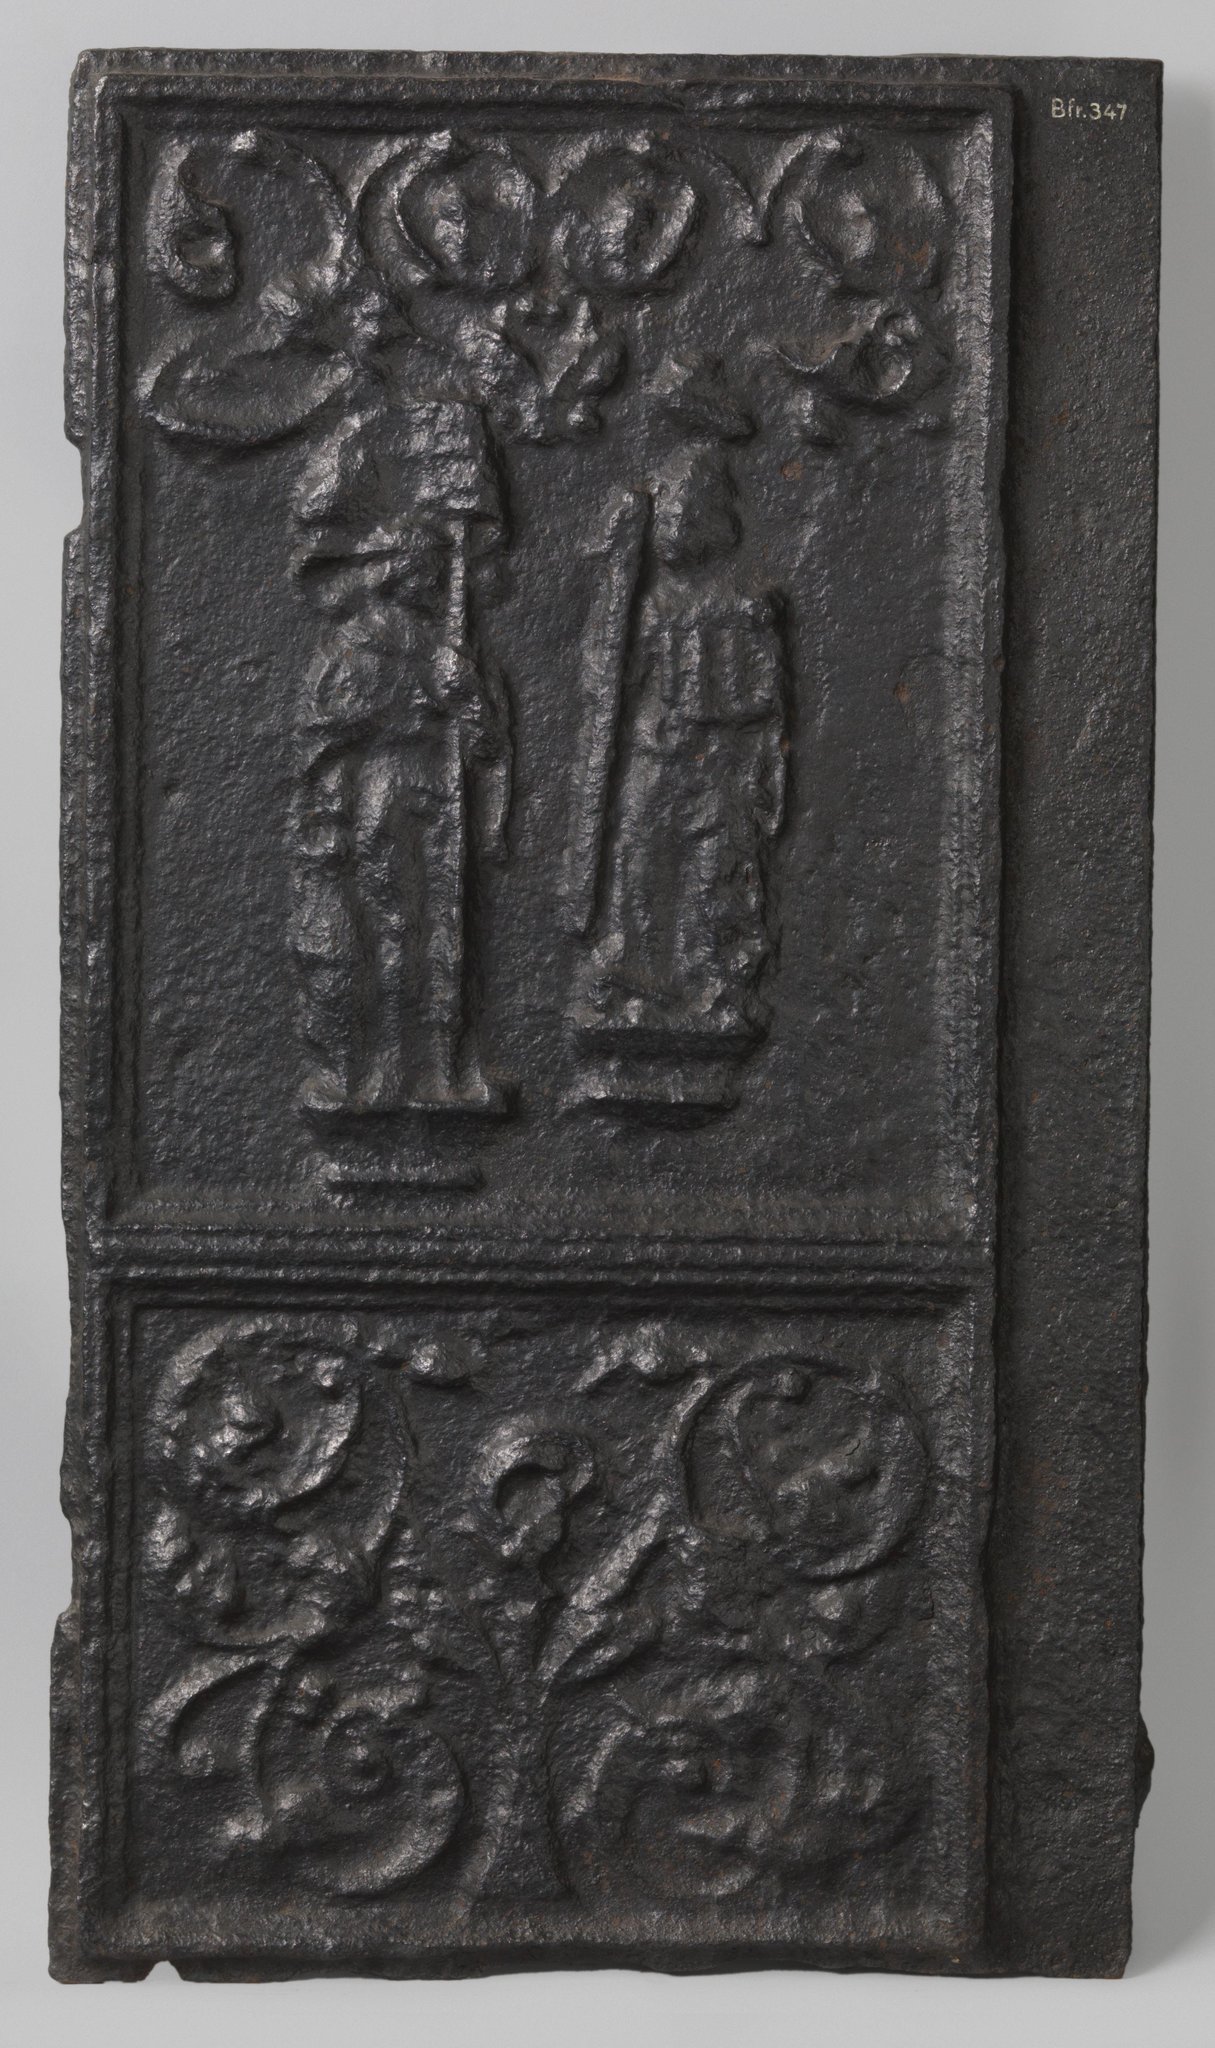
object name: stove plate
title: Kachelplaat met twee heiligen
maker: Anonymous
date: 1550-1600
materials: iron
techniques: casting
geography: germany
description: Kachelplaat van gietijzer, verdeeld in twee zones. In de bovenste zone twee heilgenfiguren op consoles met boven hen gekrulde ranken. In de lijkt een boom temidden gekrulde ranken.